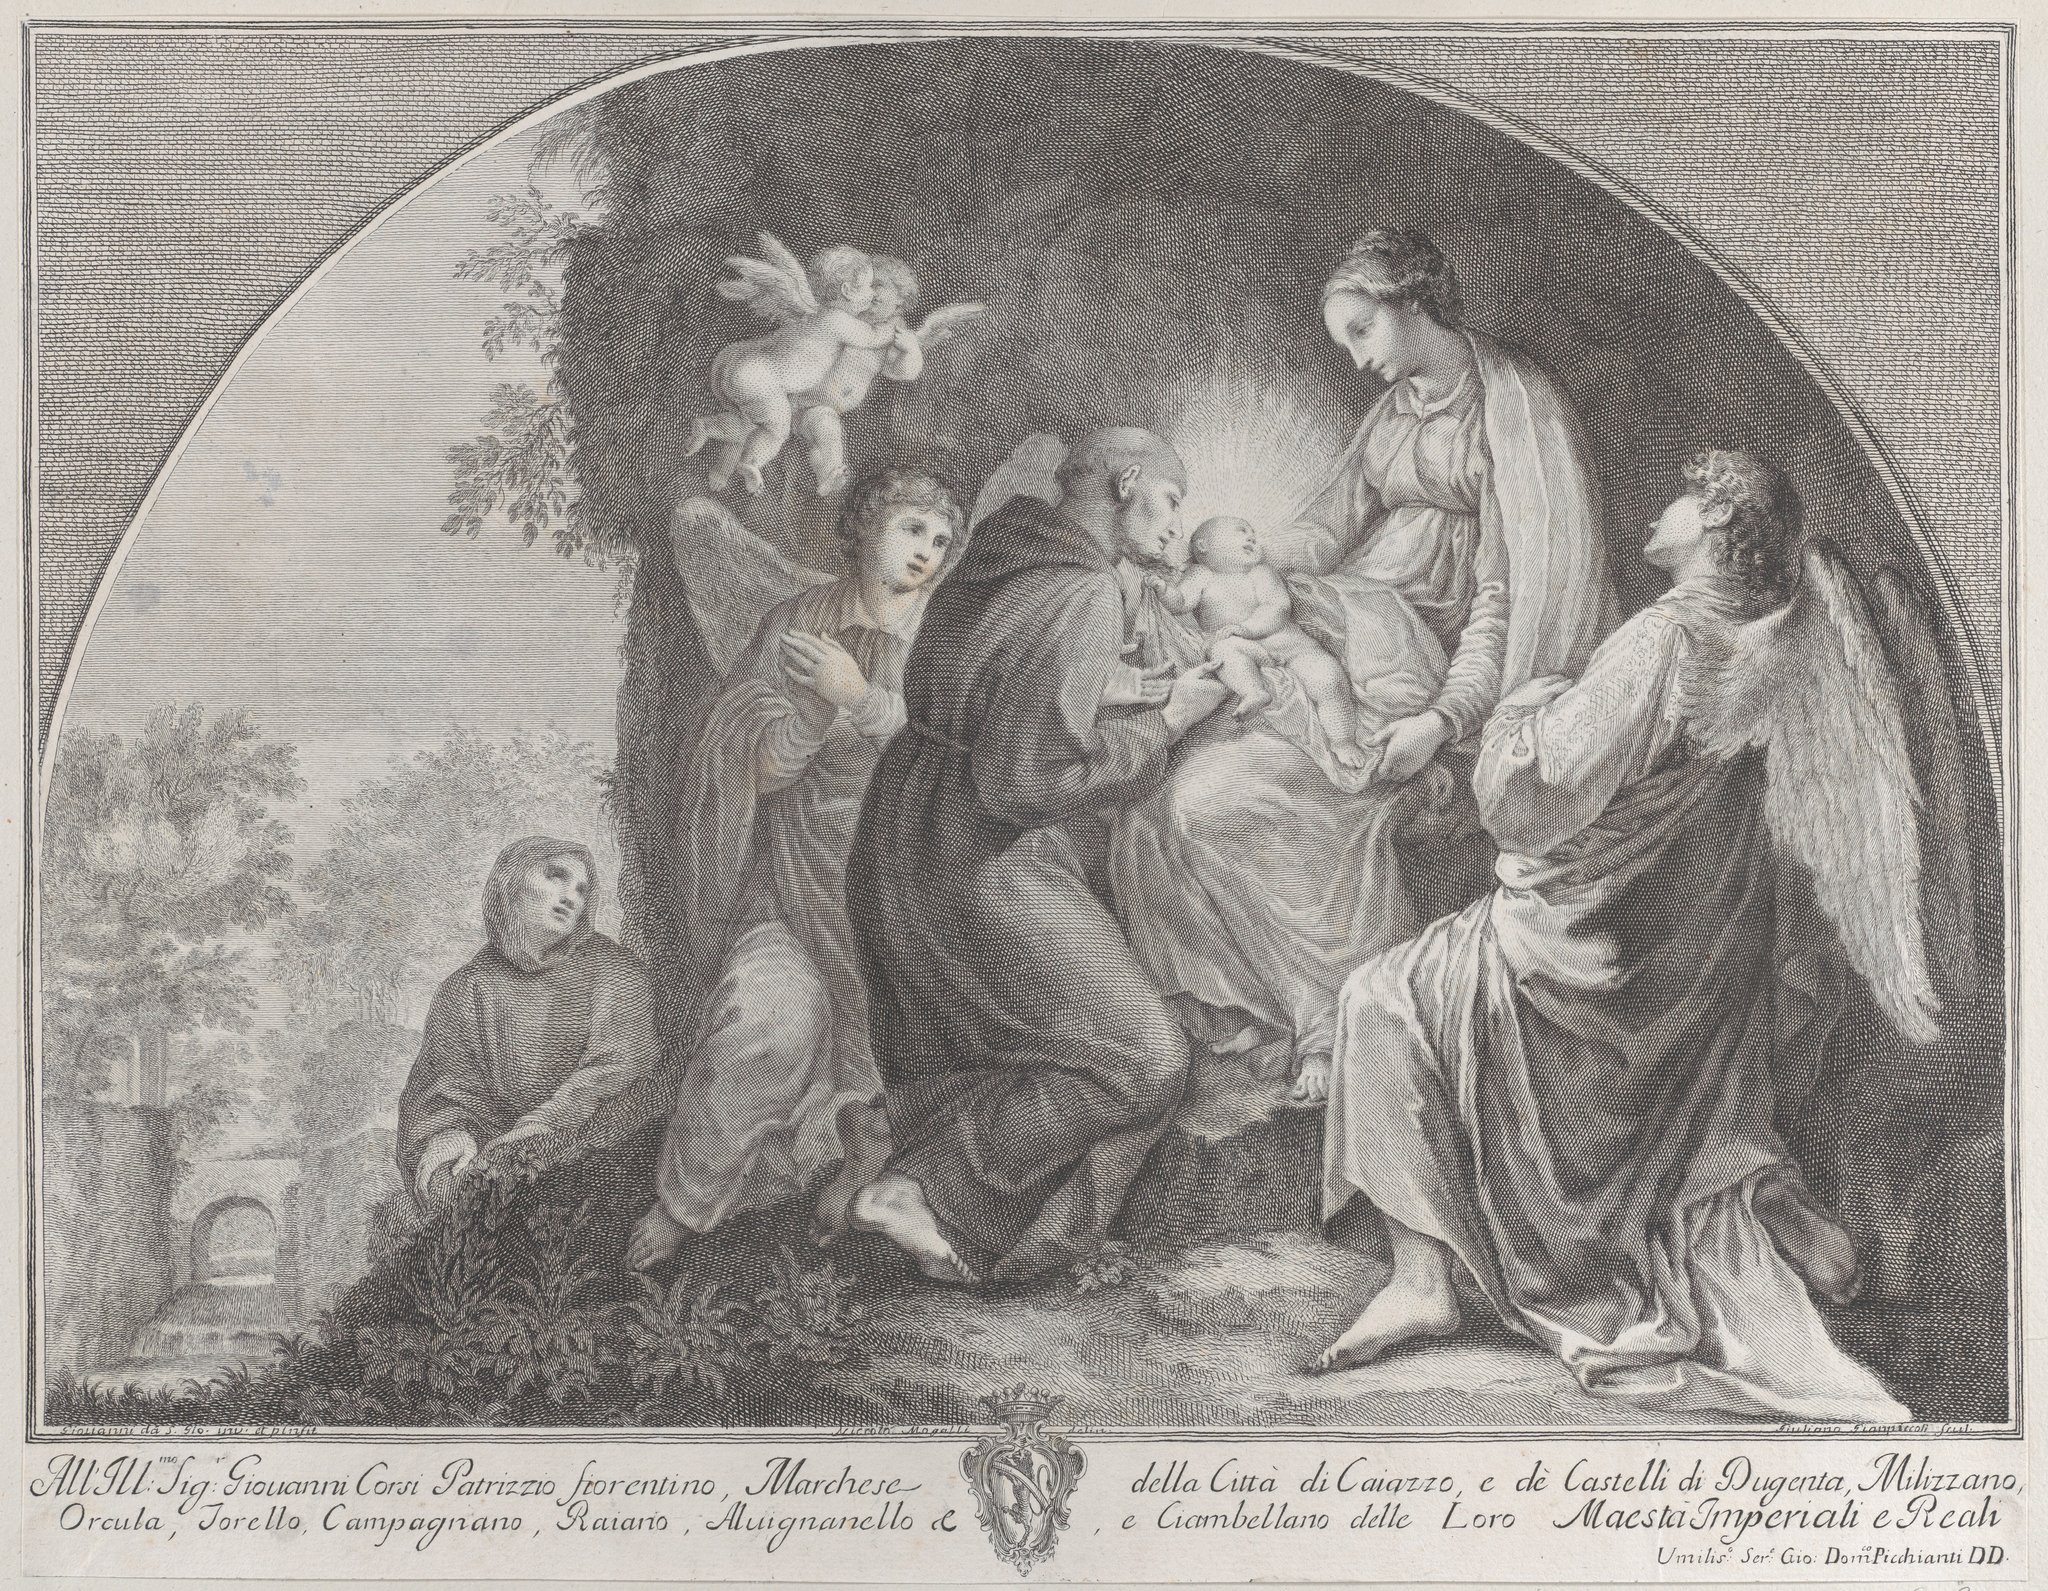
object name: print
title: Adoration of Christ by Saint Francis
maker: giuliano giampiccoli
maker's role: artist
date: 1723-1759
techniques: etching